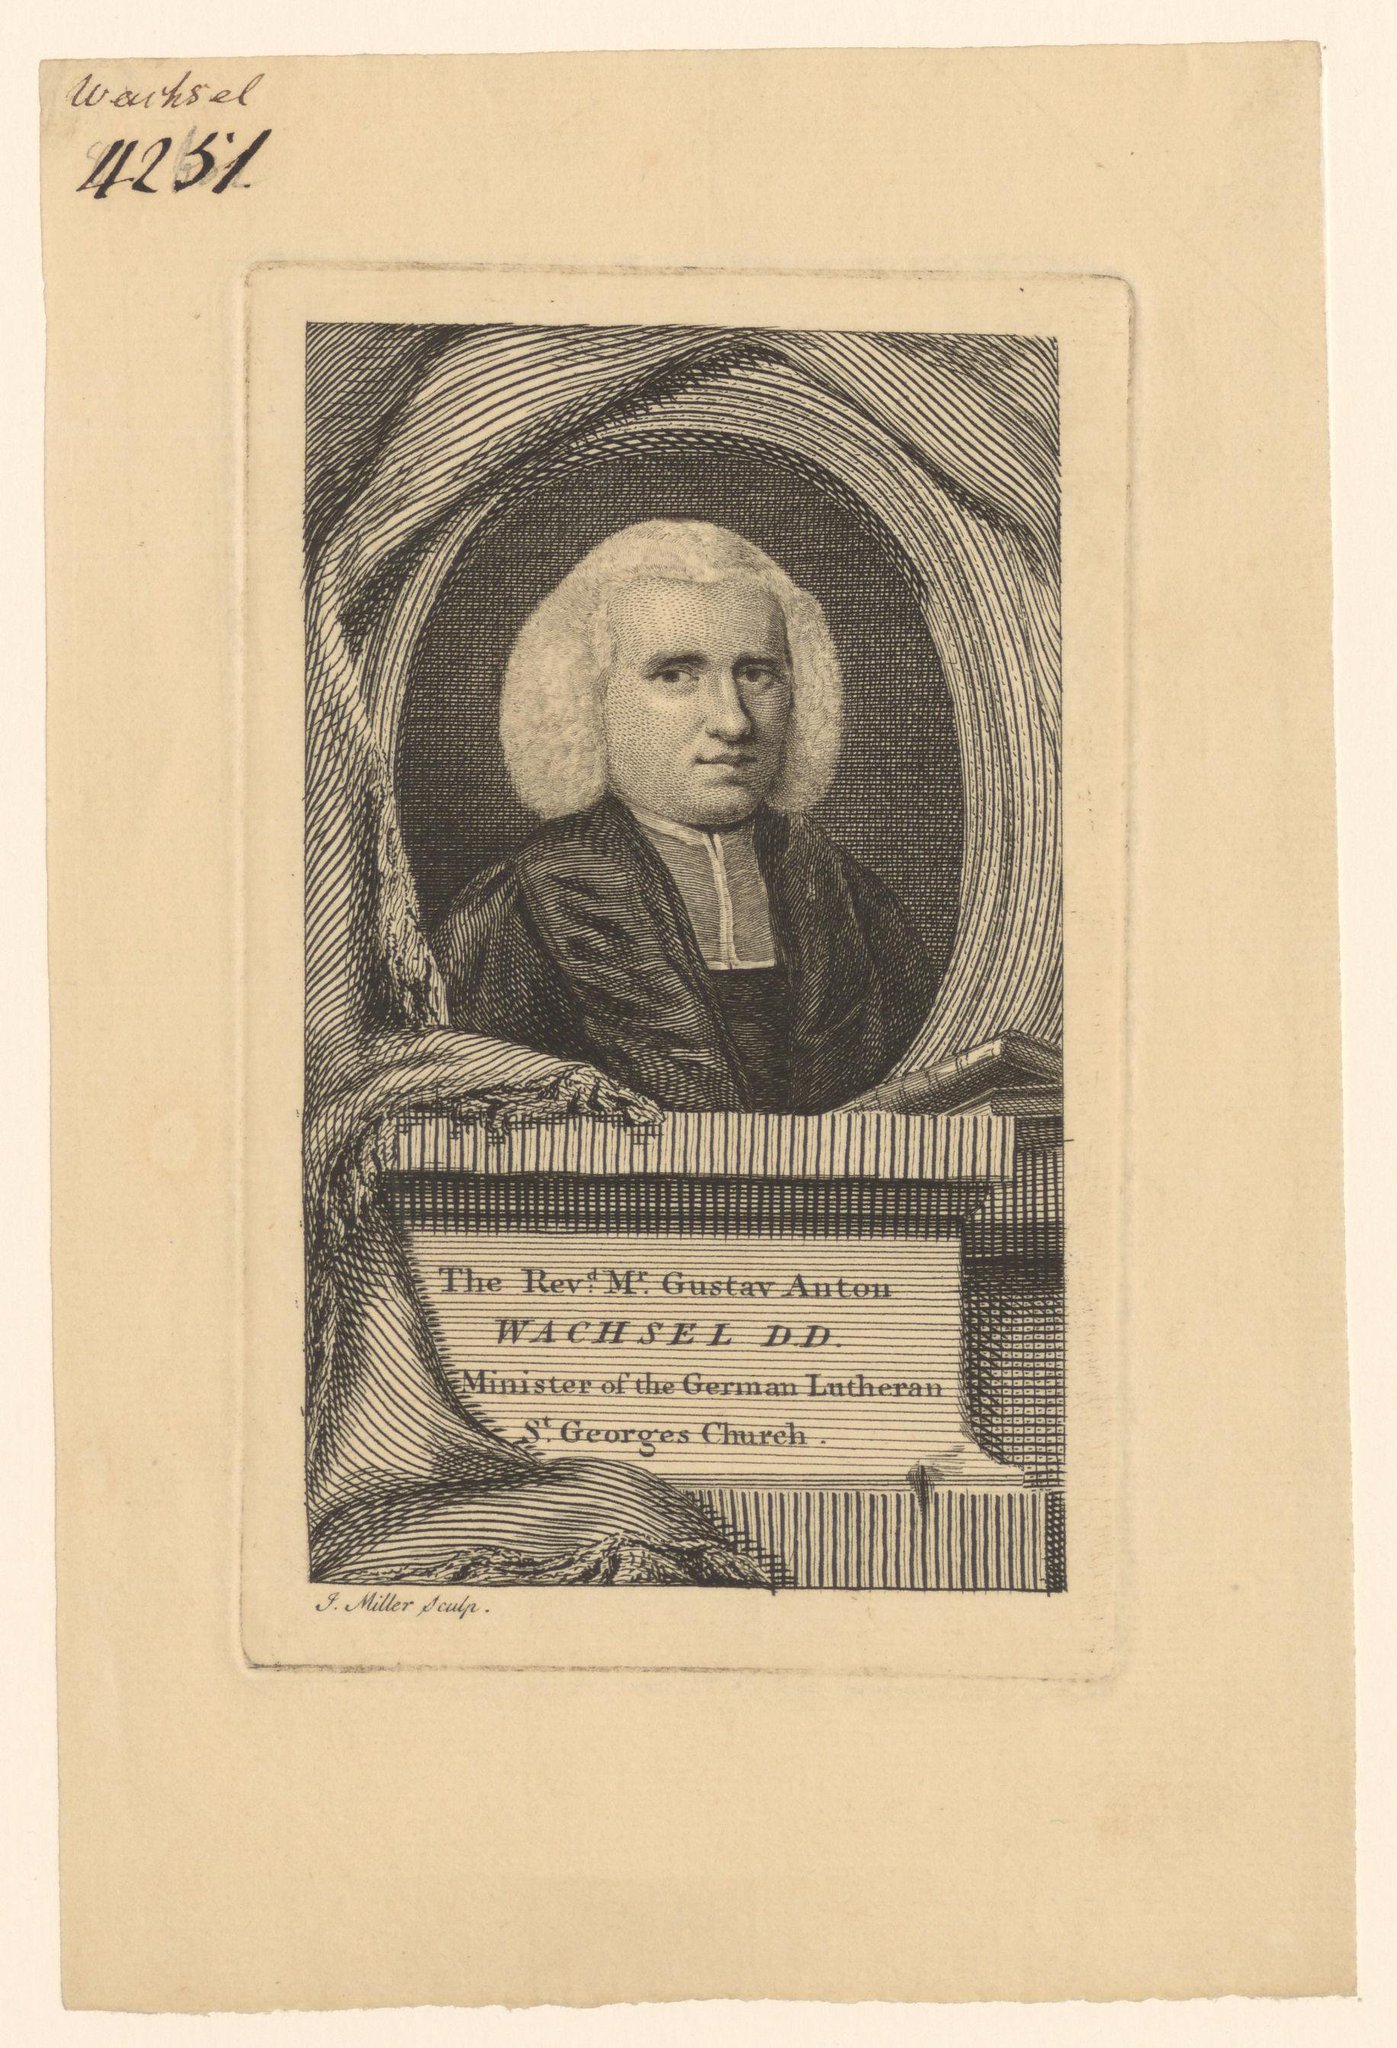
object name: print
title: Portret van Gustav Anton Wachsel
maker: johann sebastian müller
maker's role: print maker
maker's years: 1715-1790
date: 1765-1790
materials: paper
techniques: engraving, etching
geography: london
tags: historical persons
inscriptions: inscription: ‘4251’, collector's mark: Lugt 2228